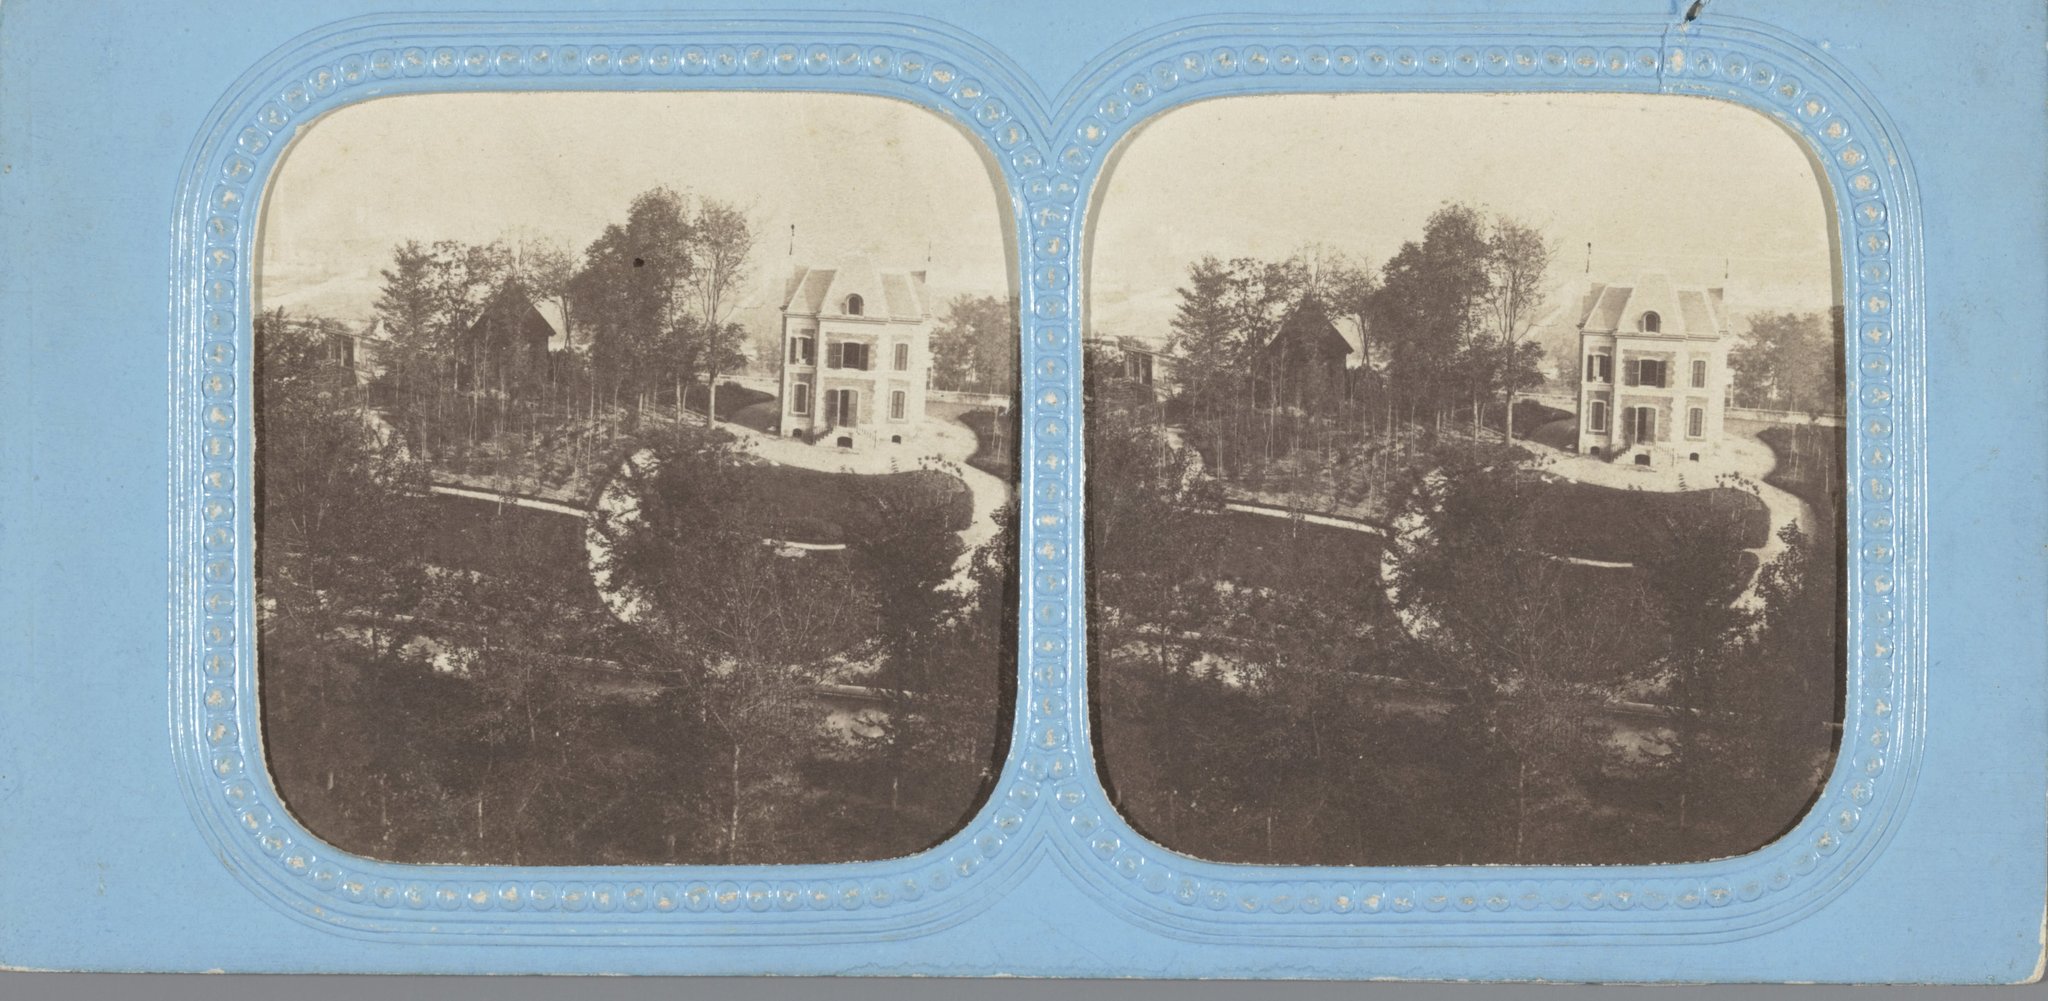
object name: photograph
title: Pavillon Henri IV, Saint-Germain-en-Laye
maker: e.l.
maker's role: publisher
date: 1860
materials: cardboard, photographic support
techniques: albumen print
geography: paris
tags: saint-germain-en-laye, pavillon henri iv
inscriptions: title: ‘Pavillon d'Henry IV // St. Germain’